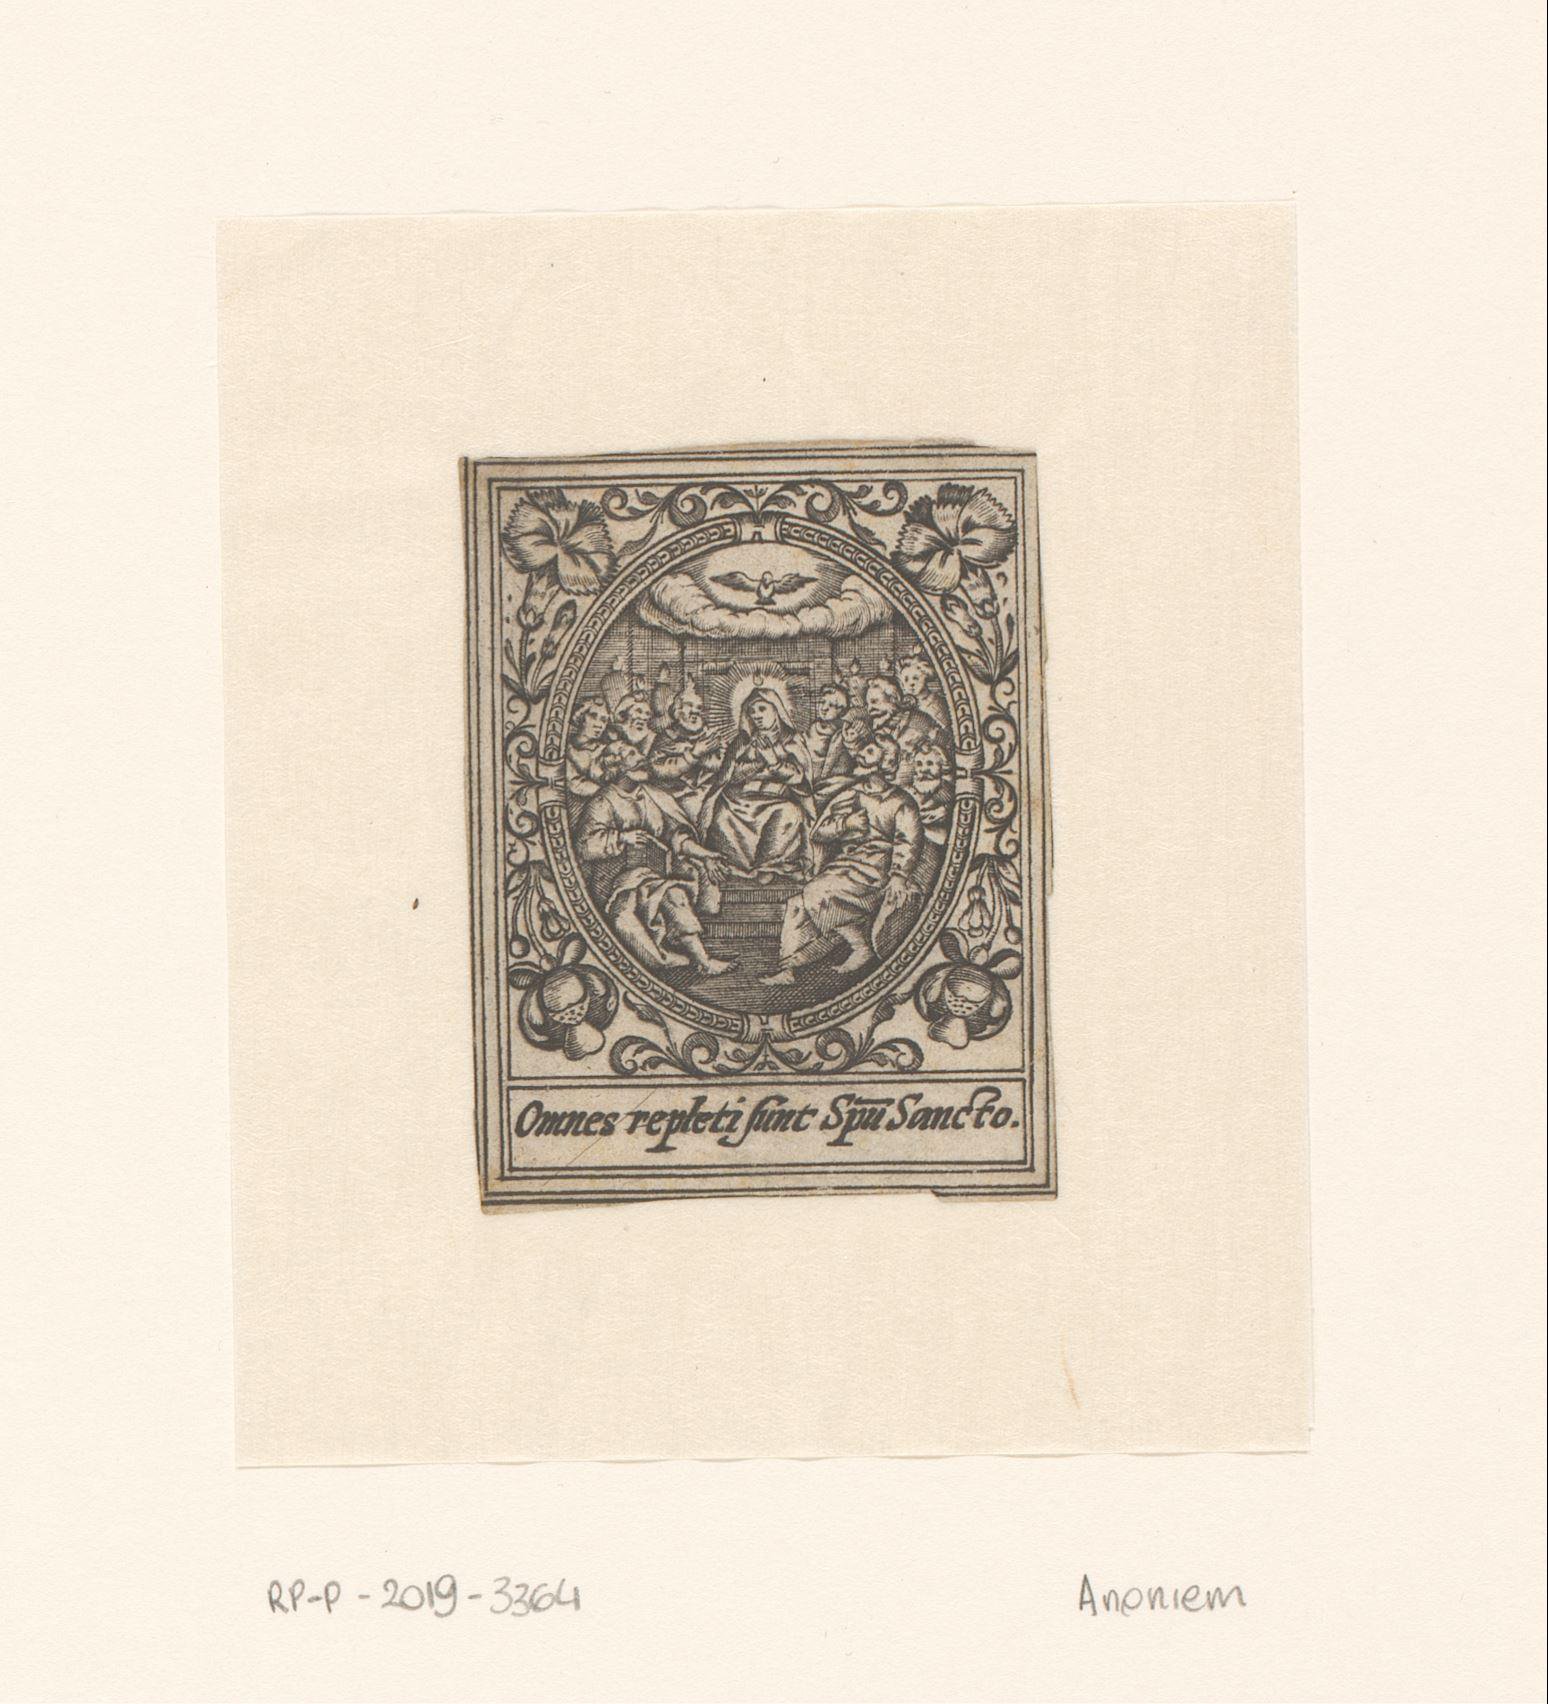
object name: print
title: Uitstorting van de Heilige Geest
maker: Anonymous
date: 1600-1699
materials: paper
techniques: engraving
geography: netherlands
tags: ornament ~ cartouche, pentecost: the holy ghost descends upon (mary and) the apostles, sometimes paul and/or representatives of the nations present (acts 2:1-4)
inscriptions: collector's mark: Lugt 2228